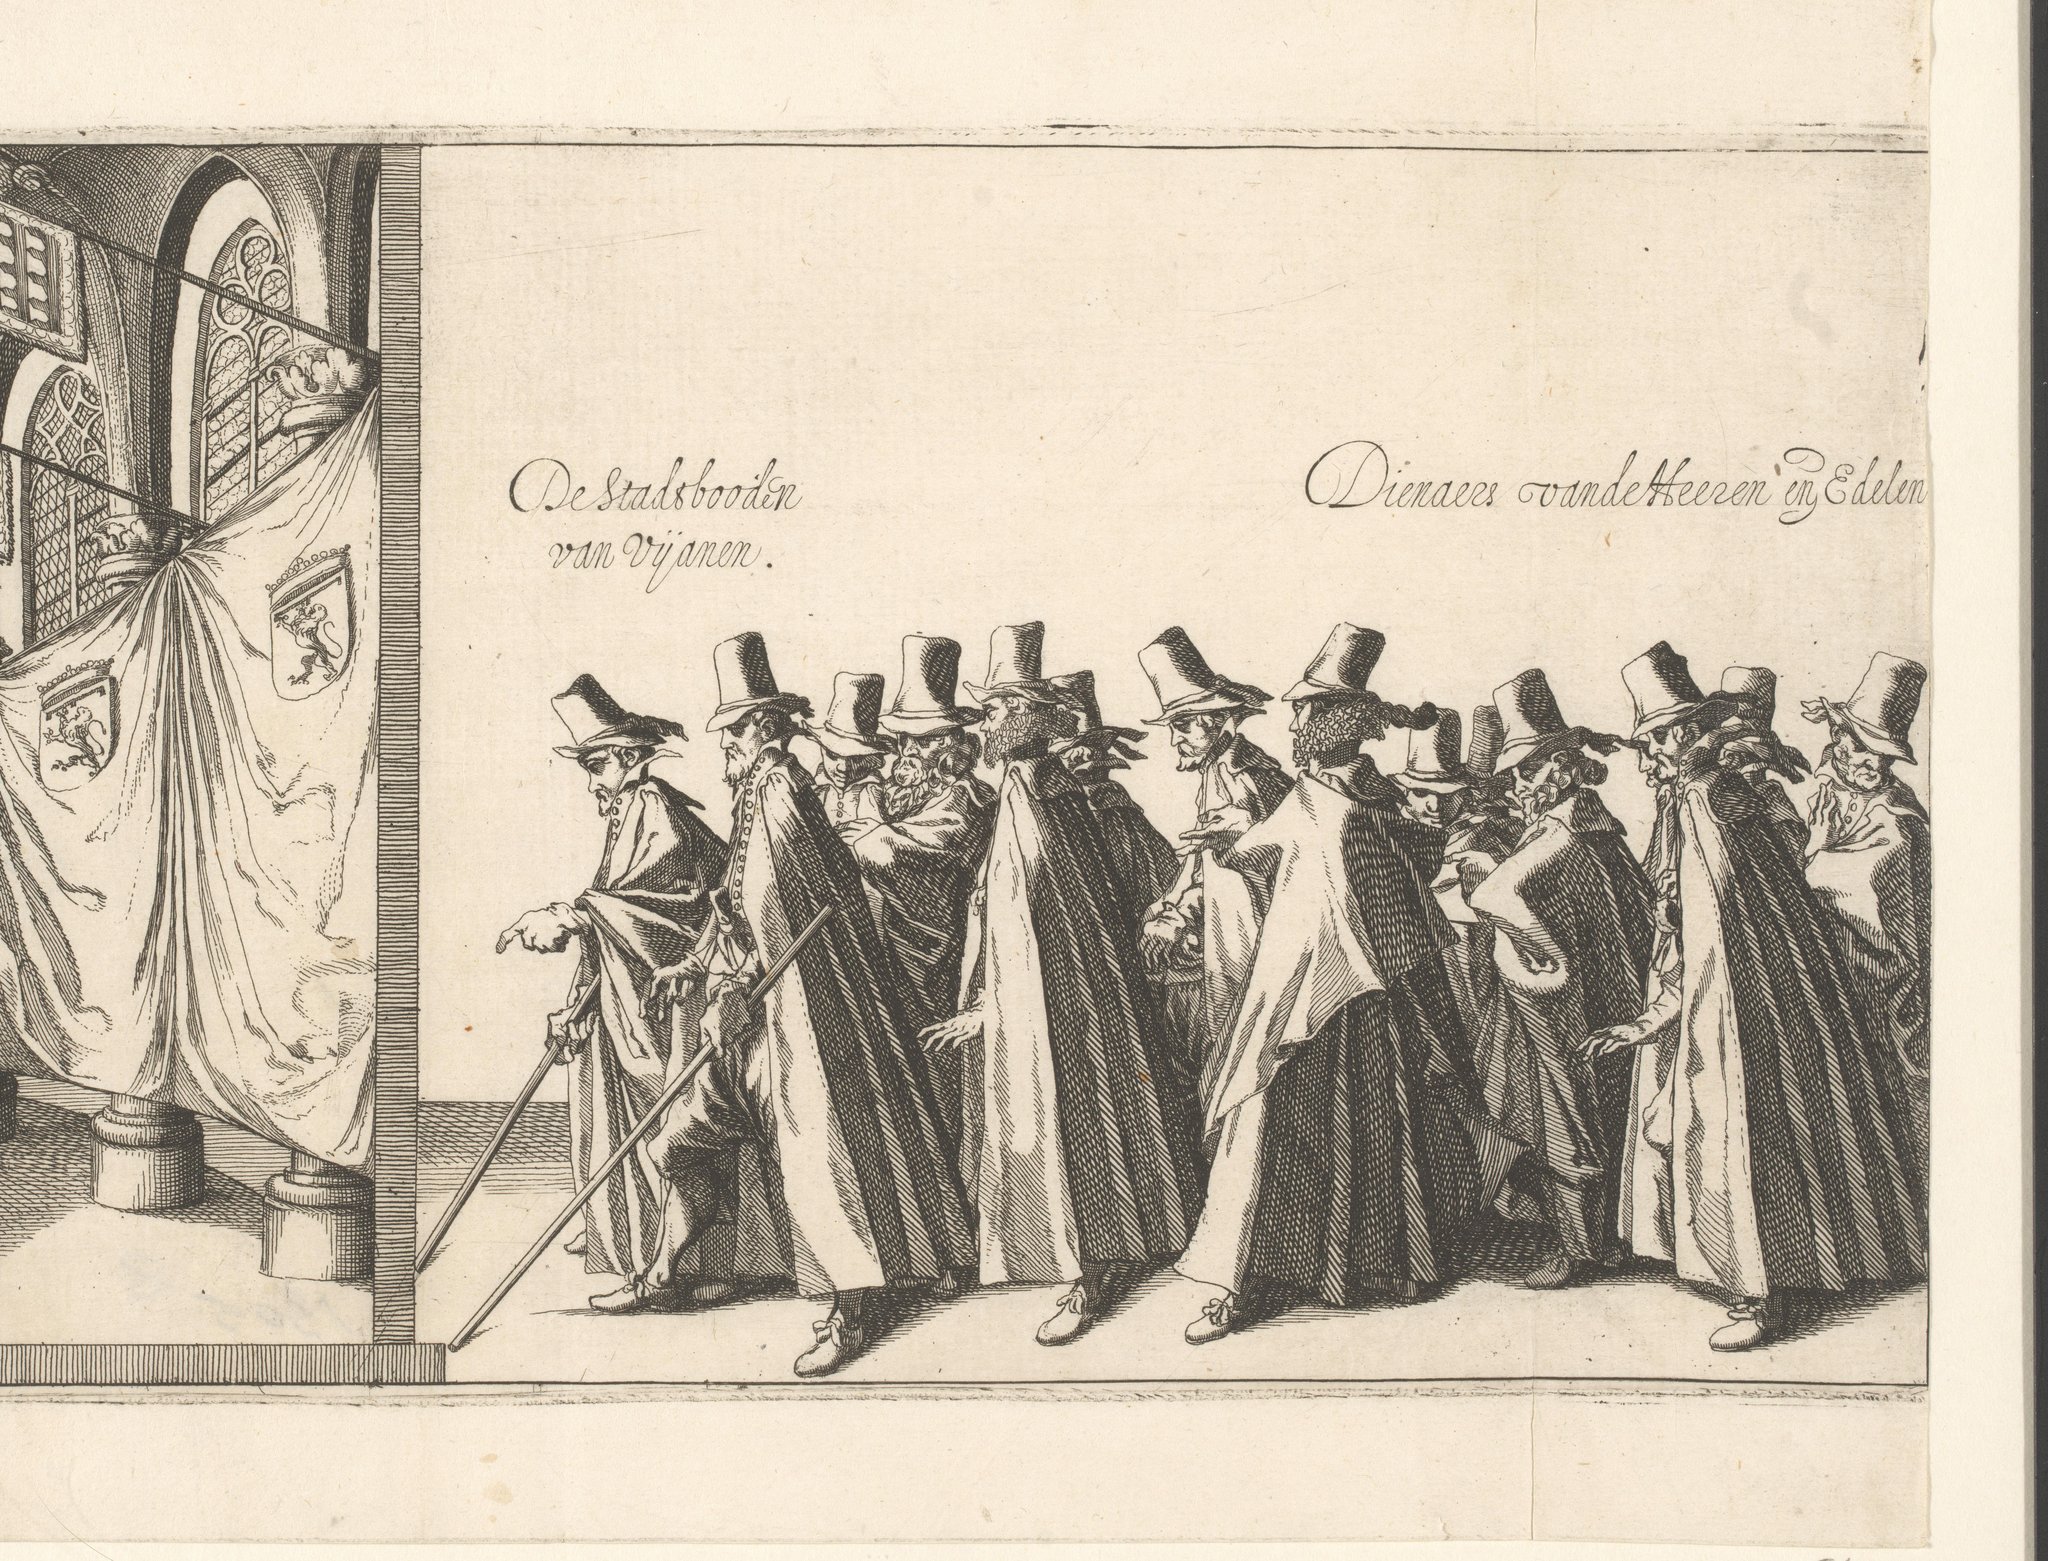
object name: print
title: Beschryvinge vande begraefnisse van (...) Walraven, Heere tot Brederoede, Vry-Heere van Vianen (...) Gedaen binnen der stede van vianen den XXIX Januari. Ano. 1615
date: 1615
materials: paper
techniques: etching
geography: northern netherlands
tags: cortege, funeral procession, grave, tomb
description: Het graf in de kerk van Vianen en de kop van de begrafenisstoet (plaat 2). Gezicht in de kerk met de ruimte om het graf afgedekt met opgehangen doeken en versierd met vaandels. Hiernaast het begin van de begrafenisstoet. Onderdeel van de serie prenten van de begrafenisoptocht van Walraven van Brederode, heer van Vianen, op 29 januari 1615 te Vianen.